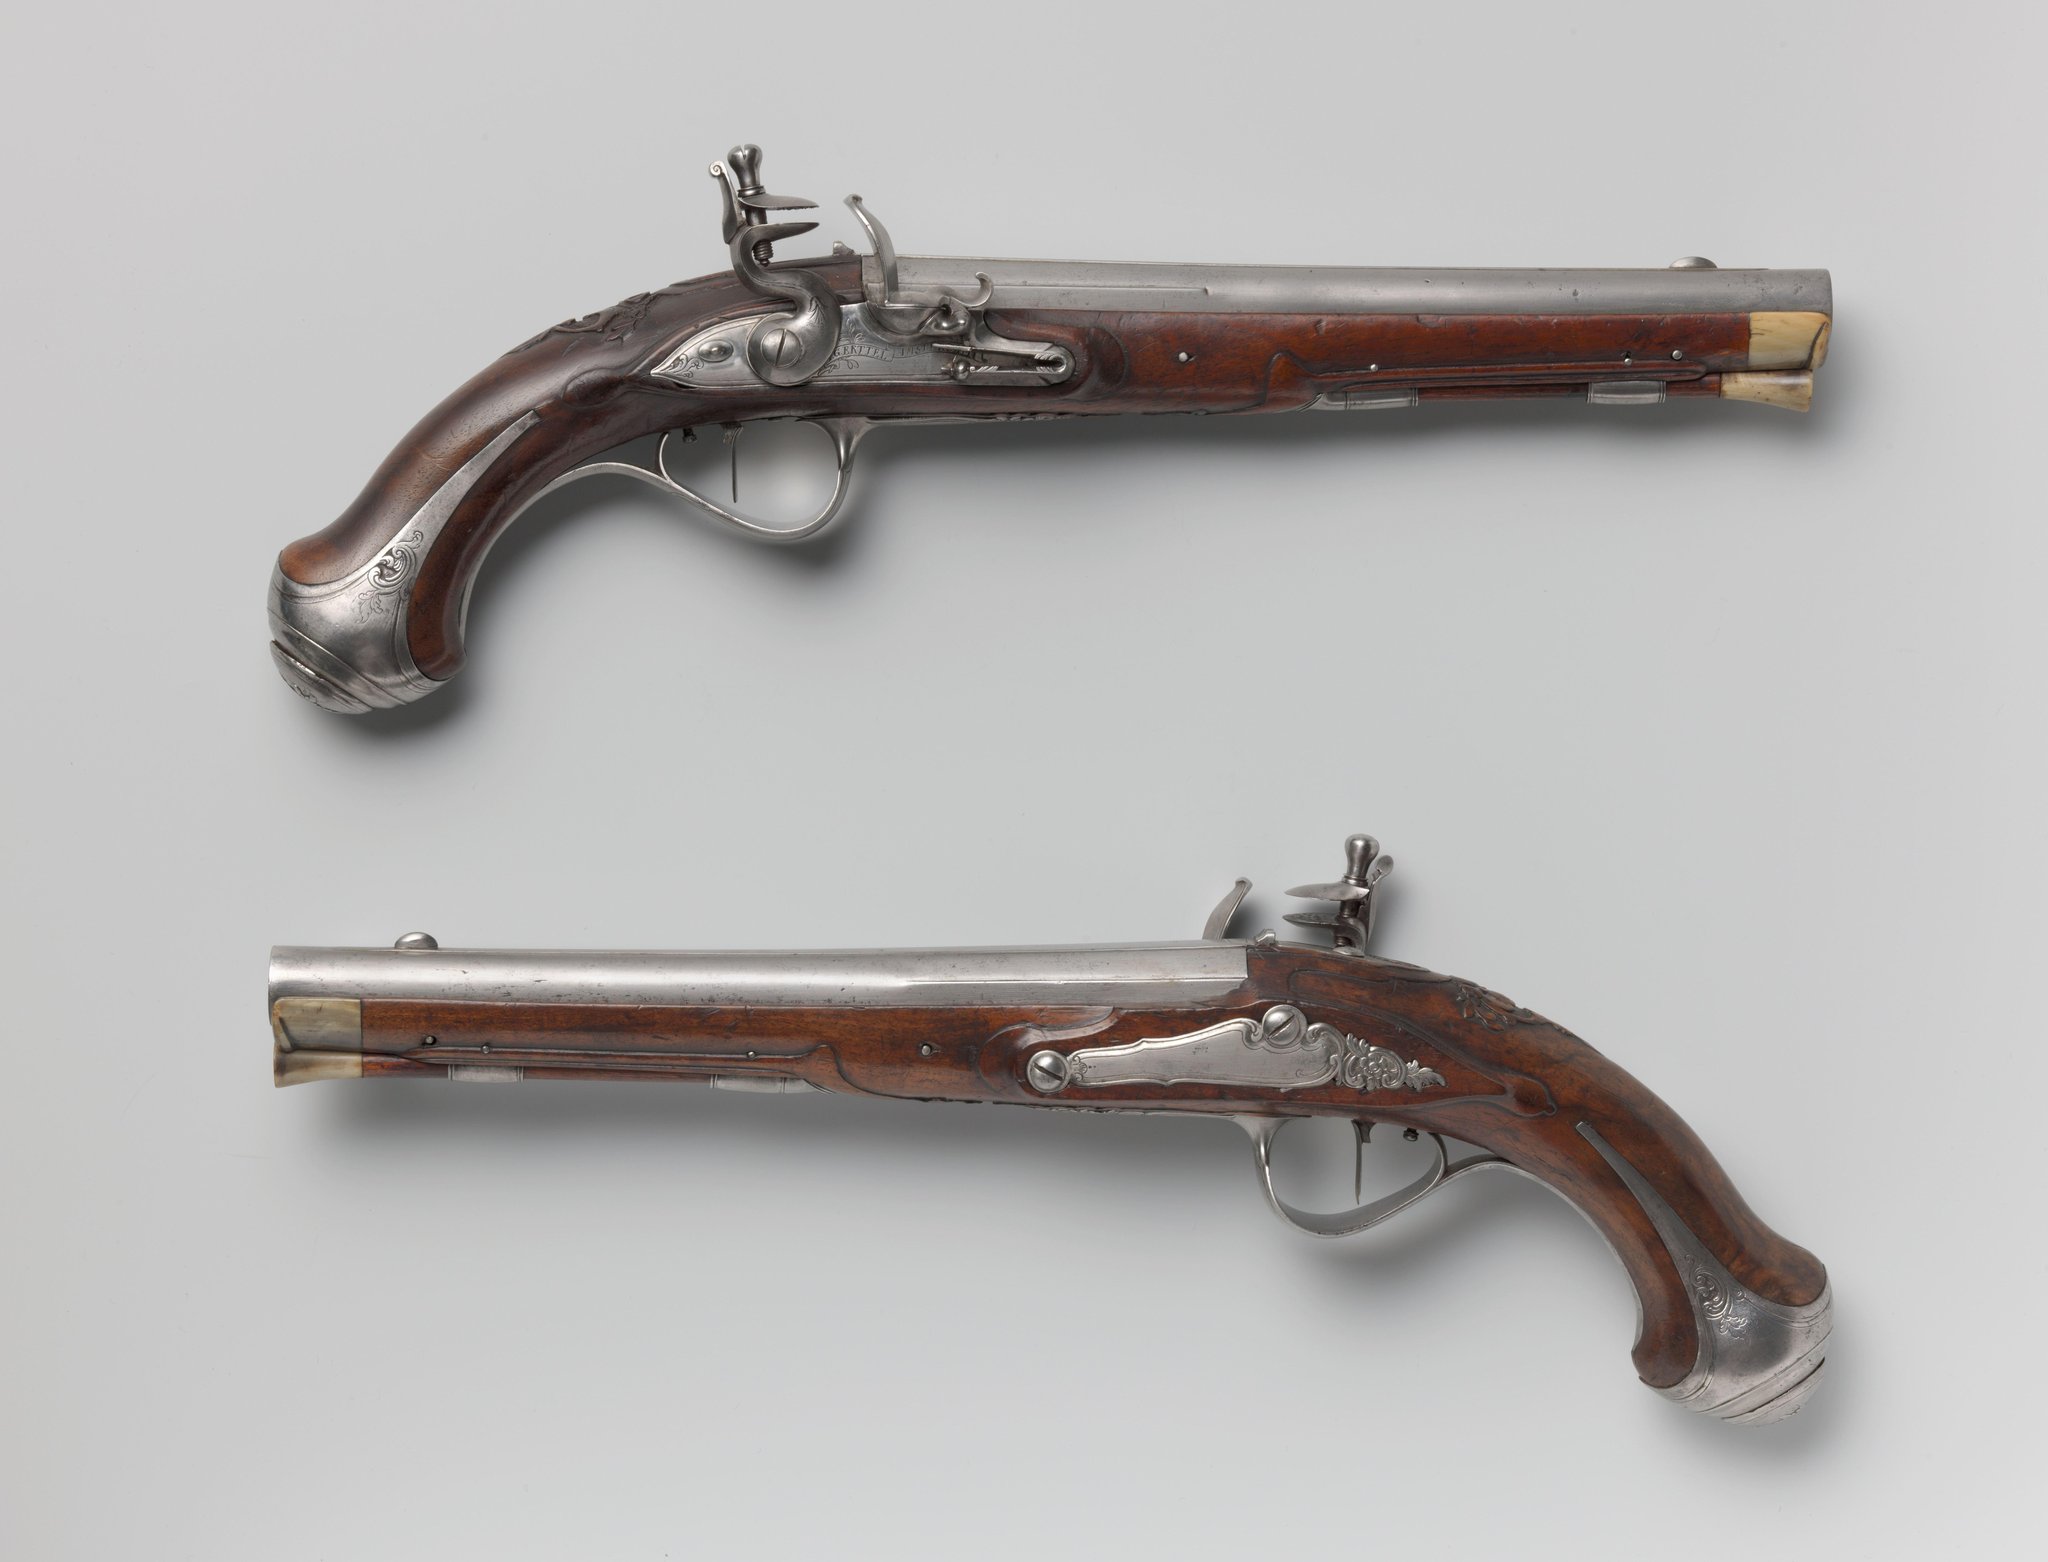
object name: flintlock pistol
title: Ruiterpistool met vuursteenslot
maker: johan george ertel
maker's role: geweermaker, pistoolmaker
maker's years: 1728-1795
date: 1760-1780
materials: horn, iron, wood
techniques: engraving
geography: amsterdam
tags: netherlands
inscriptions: mark: ‘I.G. ERTTEL.AMSTERDAM’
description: Pistool met vuursteenslot, deel van koppel. Ronde gladde loop met verhogingen. Vizierkorrel en verhoogde keep. Op de loop een wapen. Vlakke slotplaat, enigszins gegraveerd en gemerkt: I.G. ERTTEL.AMSTERDAM. IJzeren pan met vuurscherm. Zwanenhalshaan. Fraai bewerkte ijzeren zijplaat en beslag. Eenvoudig bewerkte lade. Houten laadstok, onderkant van hoorn.